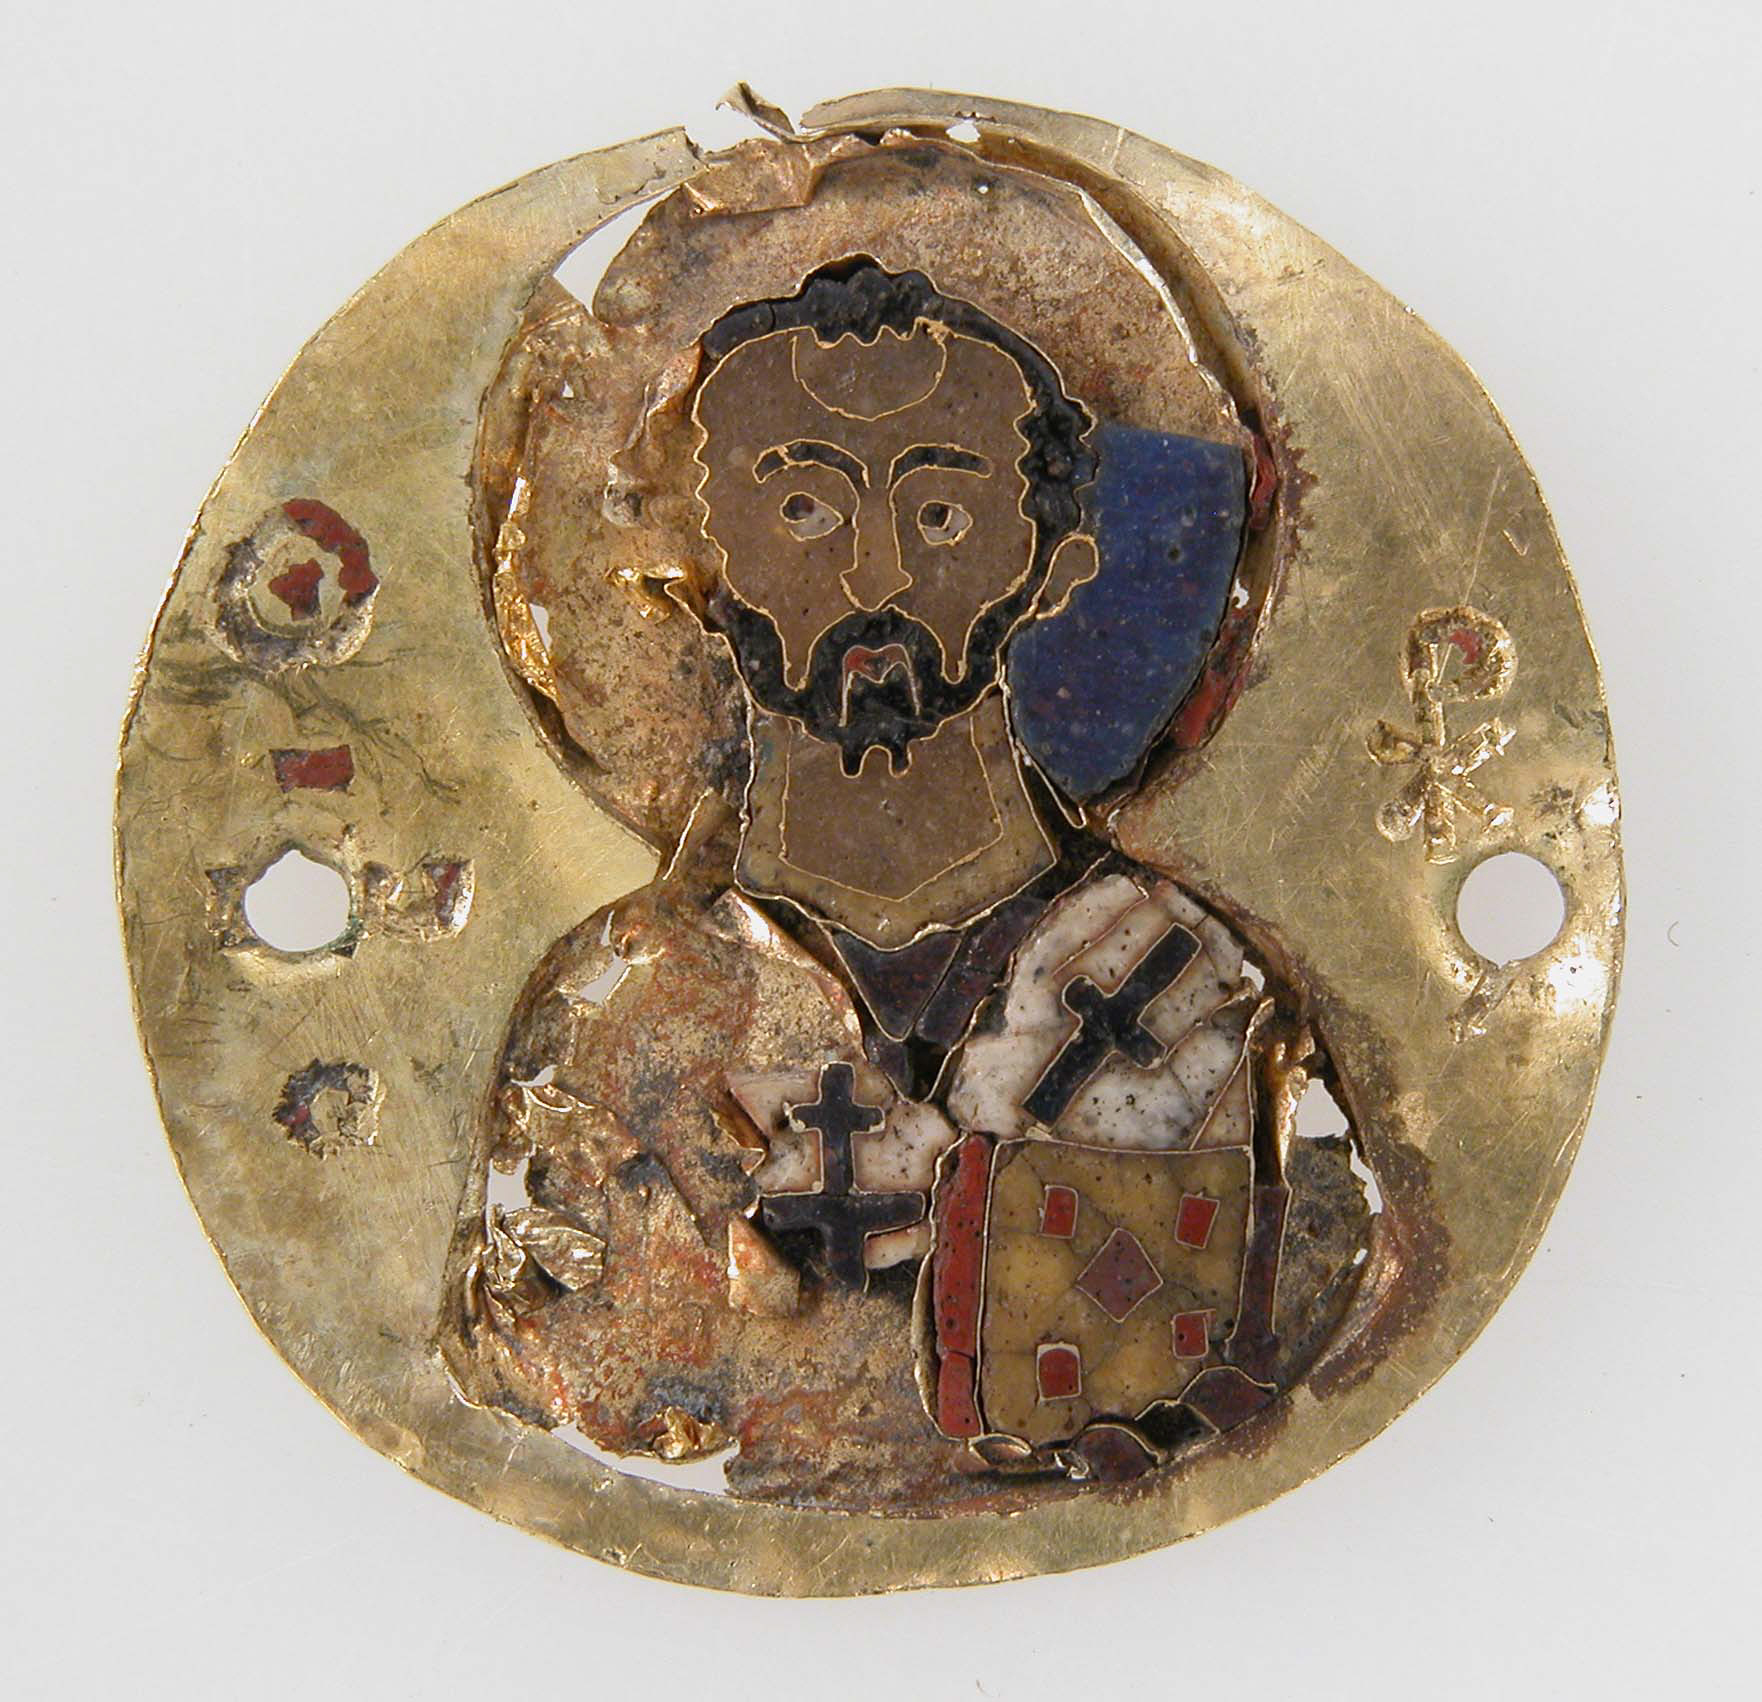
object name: medallion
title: Medallion of St. John Chrysostom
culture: byzantine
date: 901-1100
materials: enamel, gold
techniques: enamel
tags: men,saints